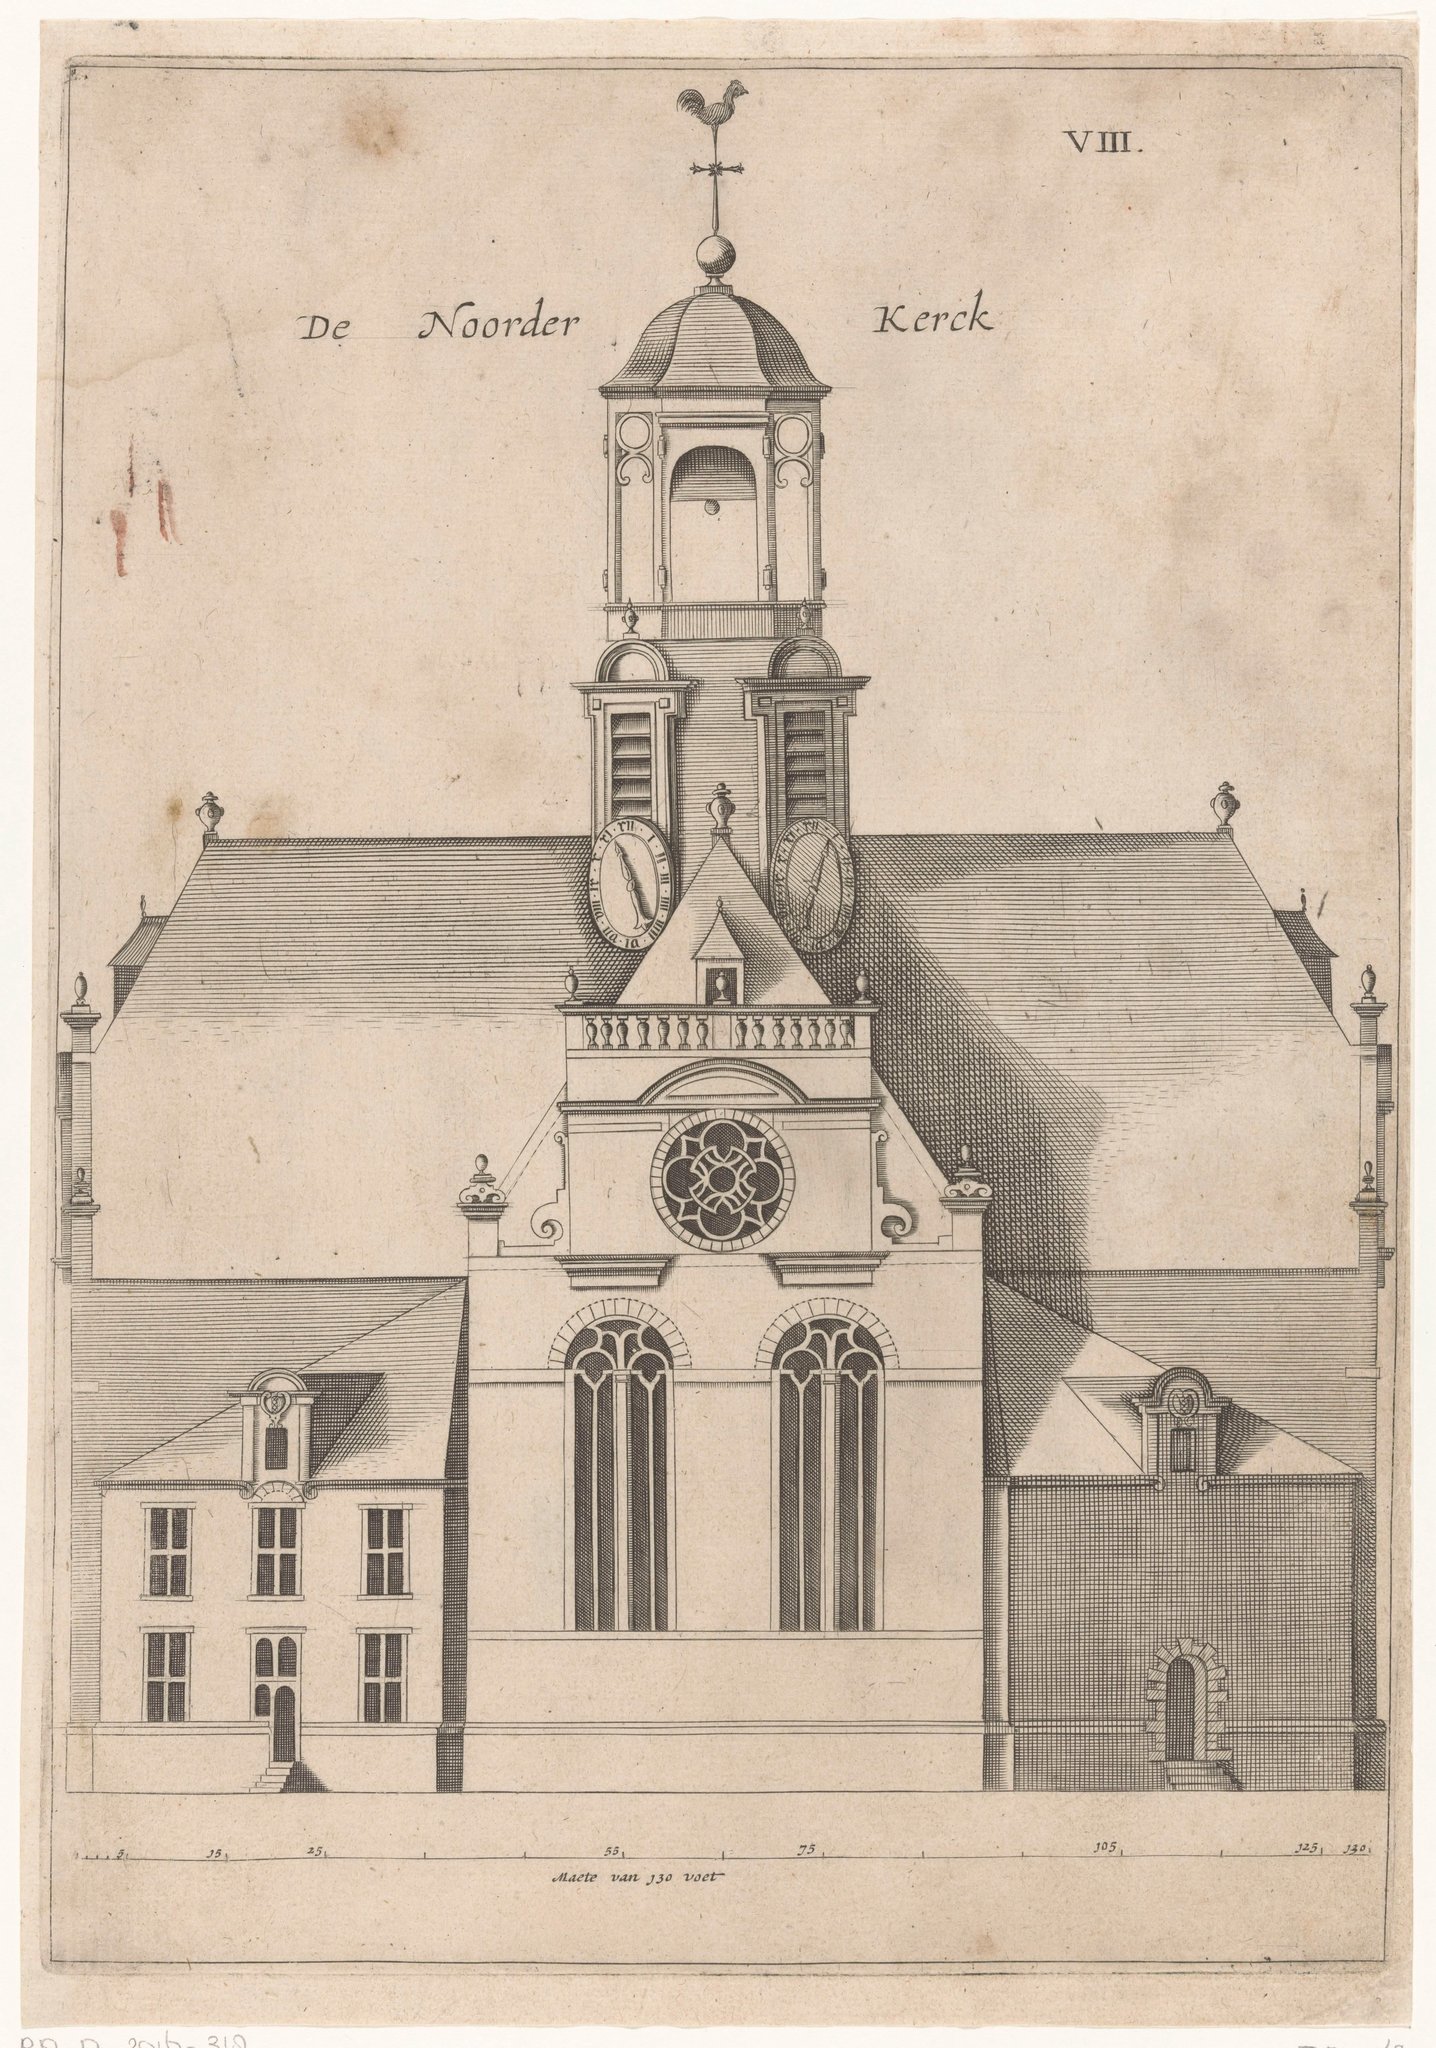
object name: ornament print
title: De Noorder Kerck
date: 1631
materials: paper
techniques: engraving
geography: amsterdam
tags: parts of church exterior and annexes: façade, exterior ~ architectural design or model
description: Prent uit: Keyser, Hendrick de. Architectura moderna ofte bouwinge van onsen tyt (...) alle gedaen by (...) Amsterdam: Danckerts, Cornelis, 1631.